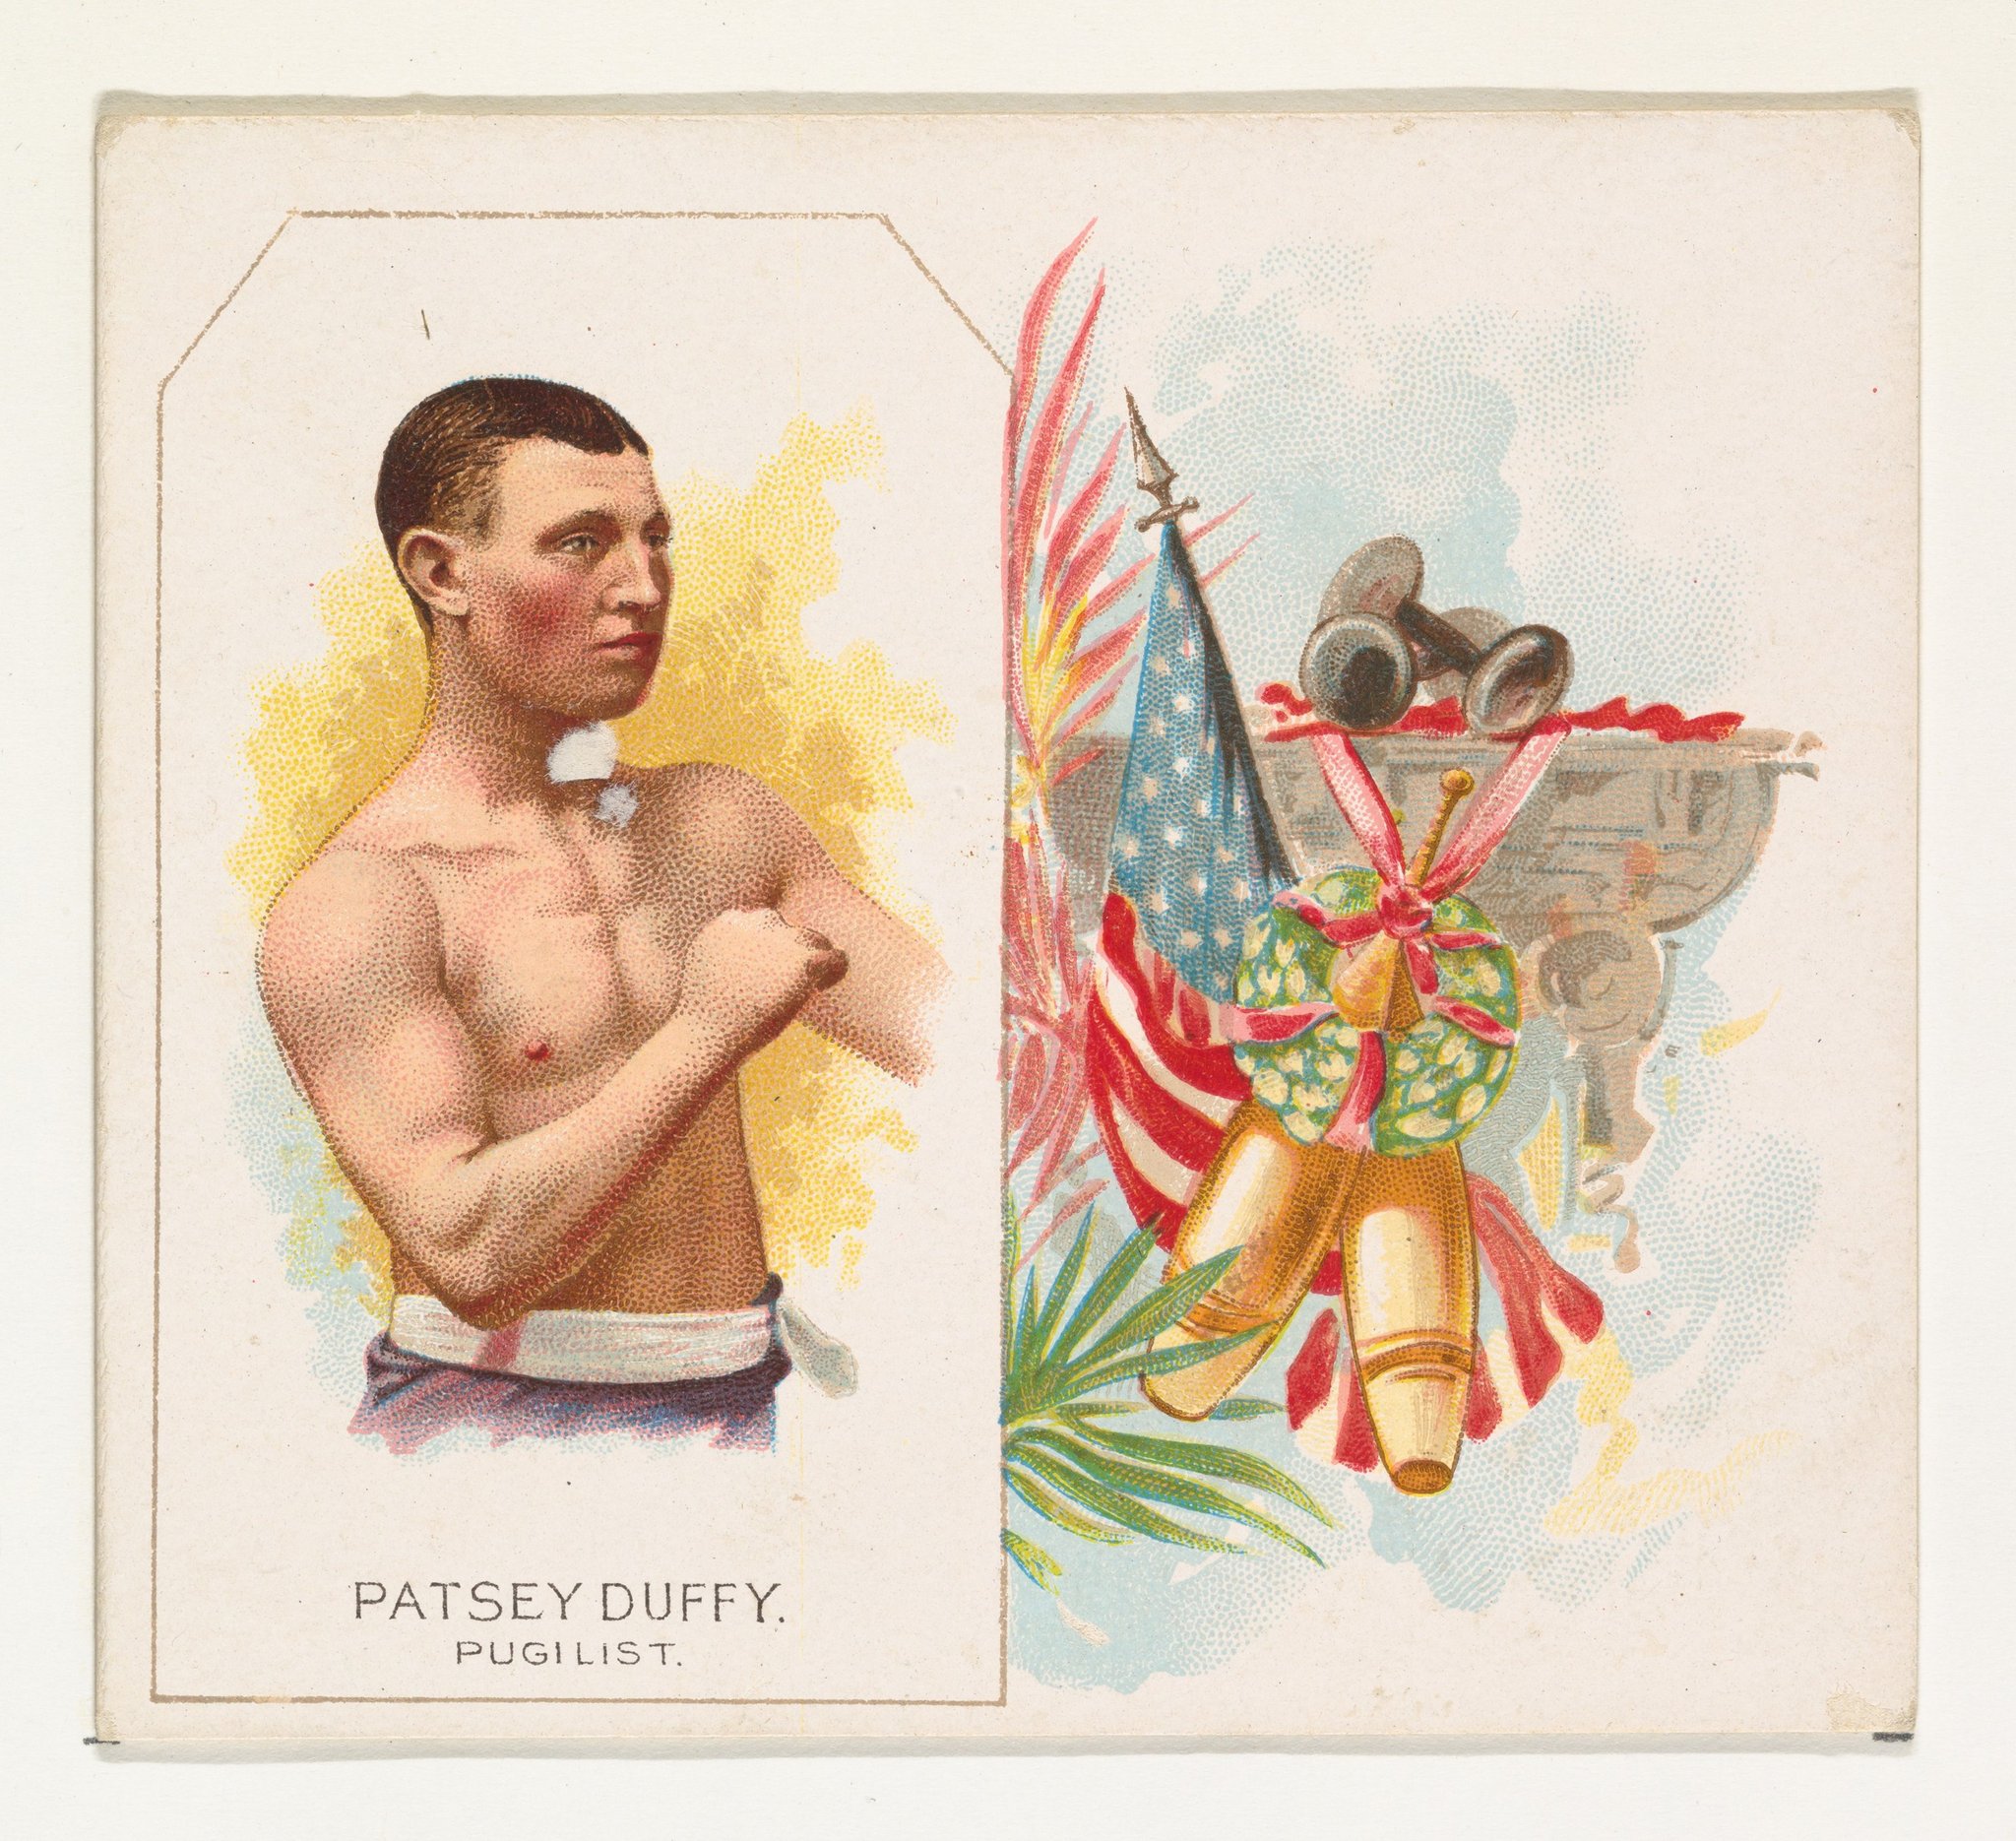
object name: print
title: Patsey Duffy, Pugilist, from World's Champions, Second Series (N43) for Allen & Ginter Cigarettes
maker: allen & ginter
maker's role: publisher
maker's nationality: american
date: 1888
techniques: lithography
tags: men,boxing,athletes